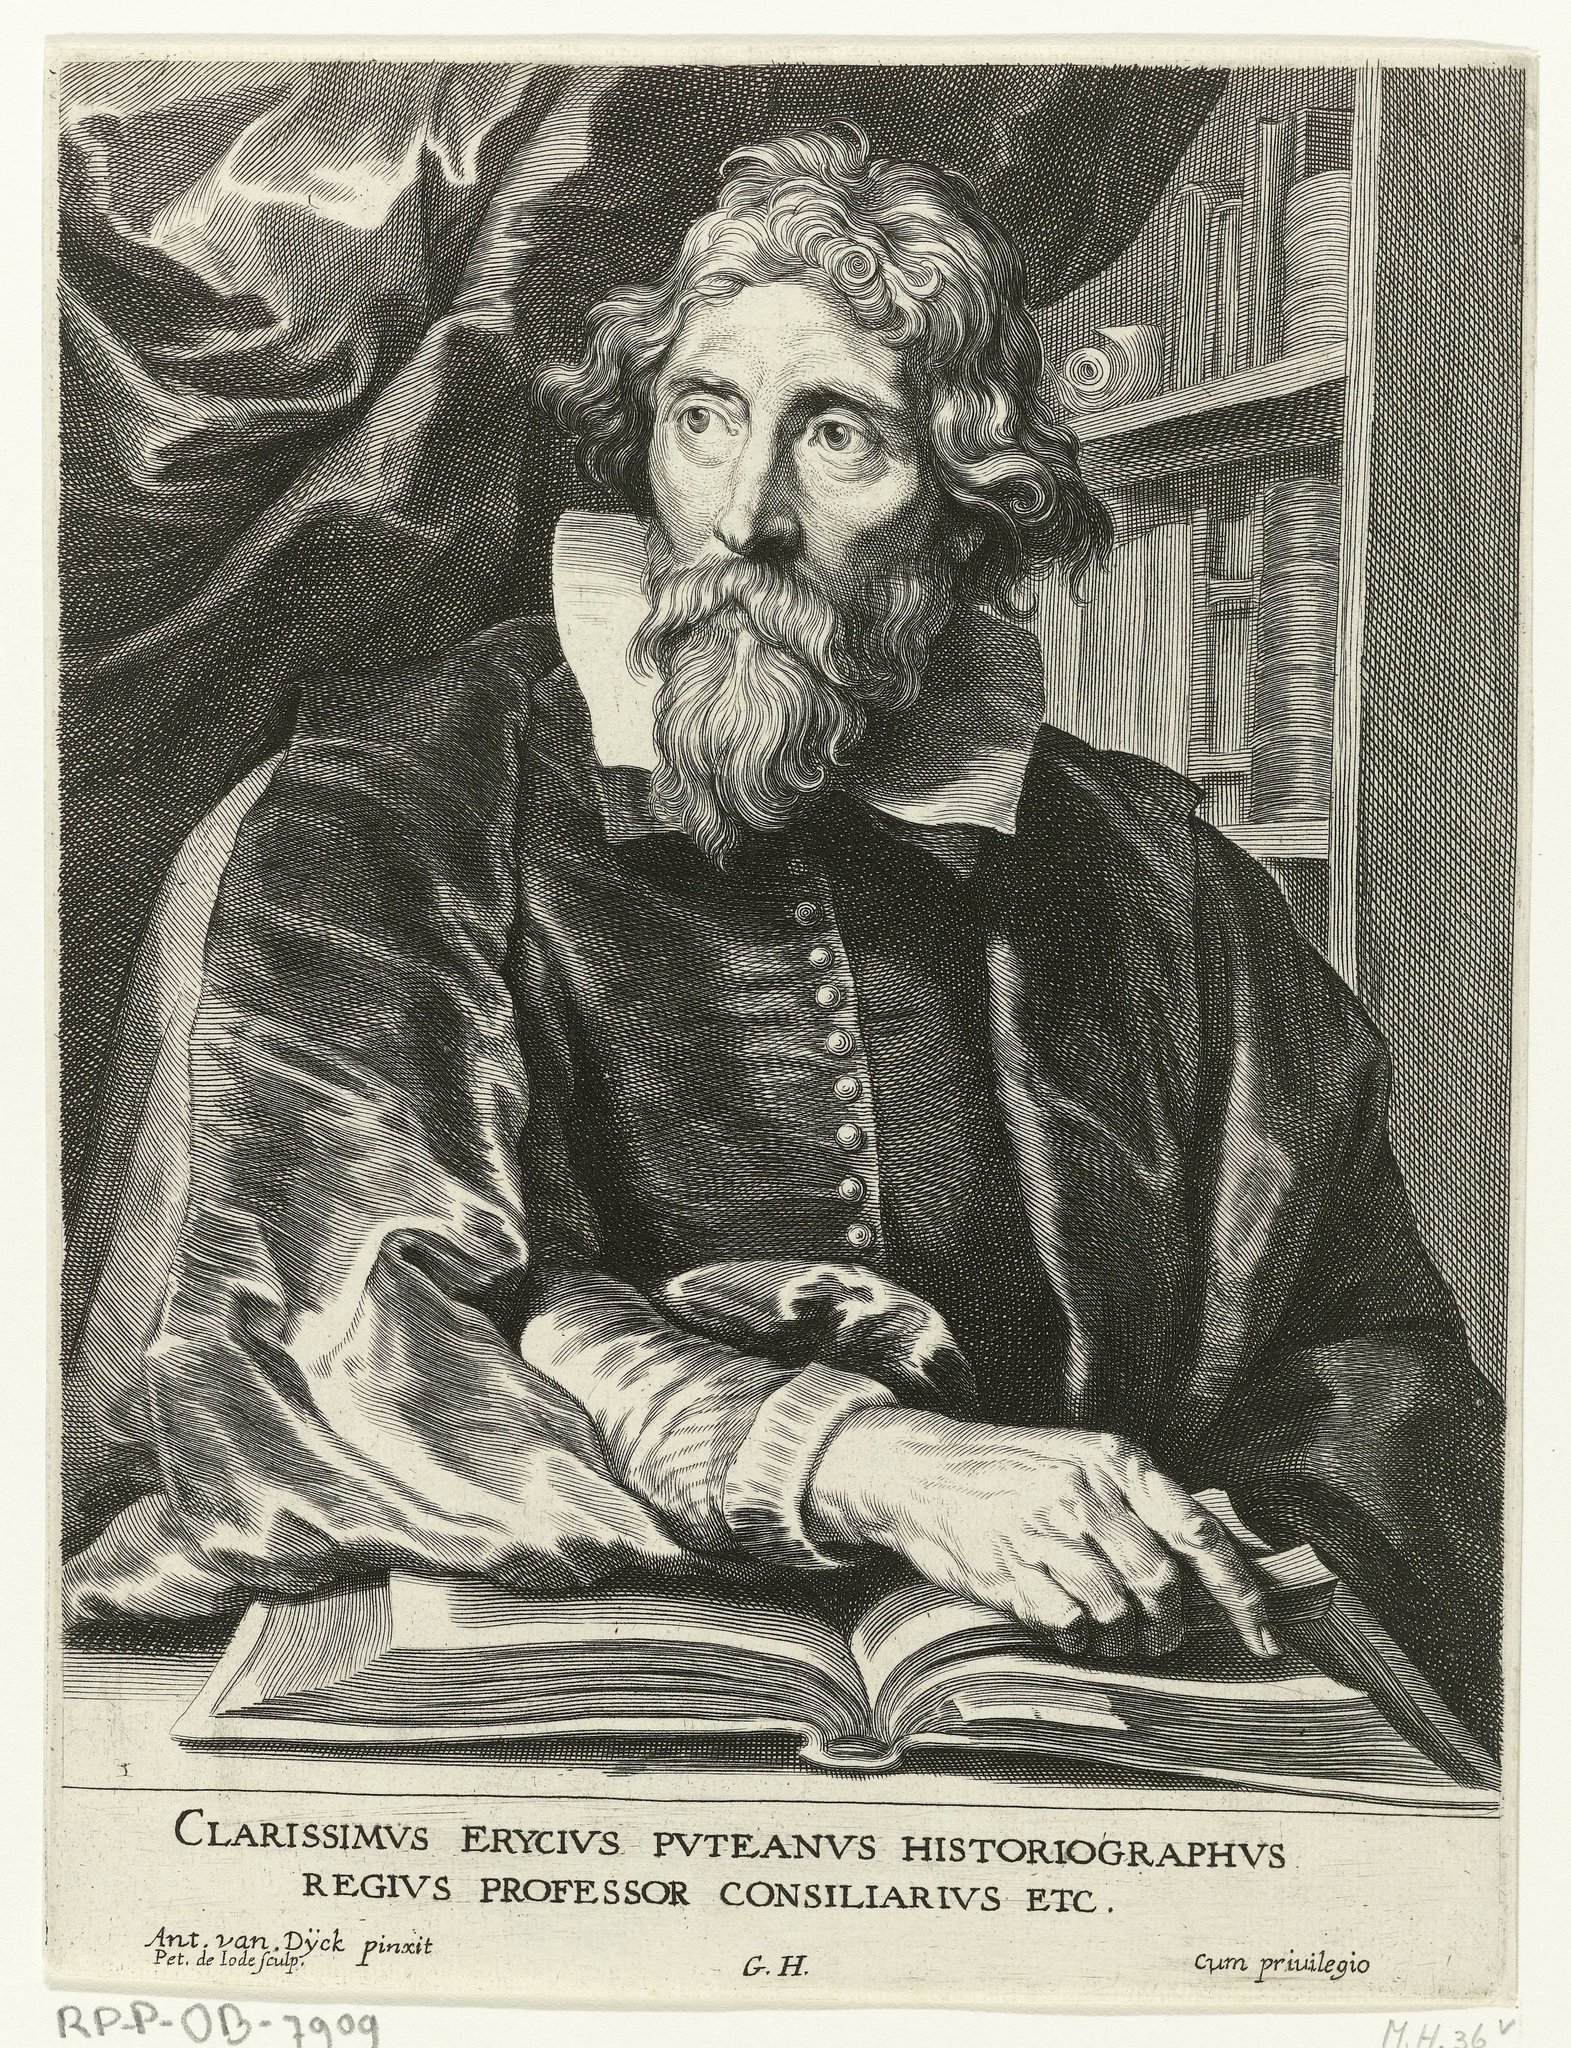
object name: print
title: Portret van Erycius Puteanus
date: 1628-1670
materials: paper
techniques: engraving, etching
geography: antwerp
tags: erycius puteanus, book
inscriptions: collector's mark: Lugt 240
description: Portret van Erycius Puteanus, ten halven lijve. Hij zit aan een bureau en slaat met zijn rechterhand de bladzijden van een boek om. Op de achtergrond een boekenkast. In de marge een tweeregelig onderschrift in het Latijn.